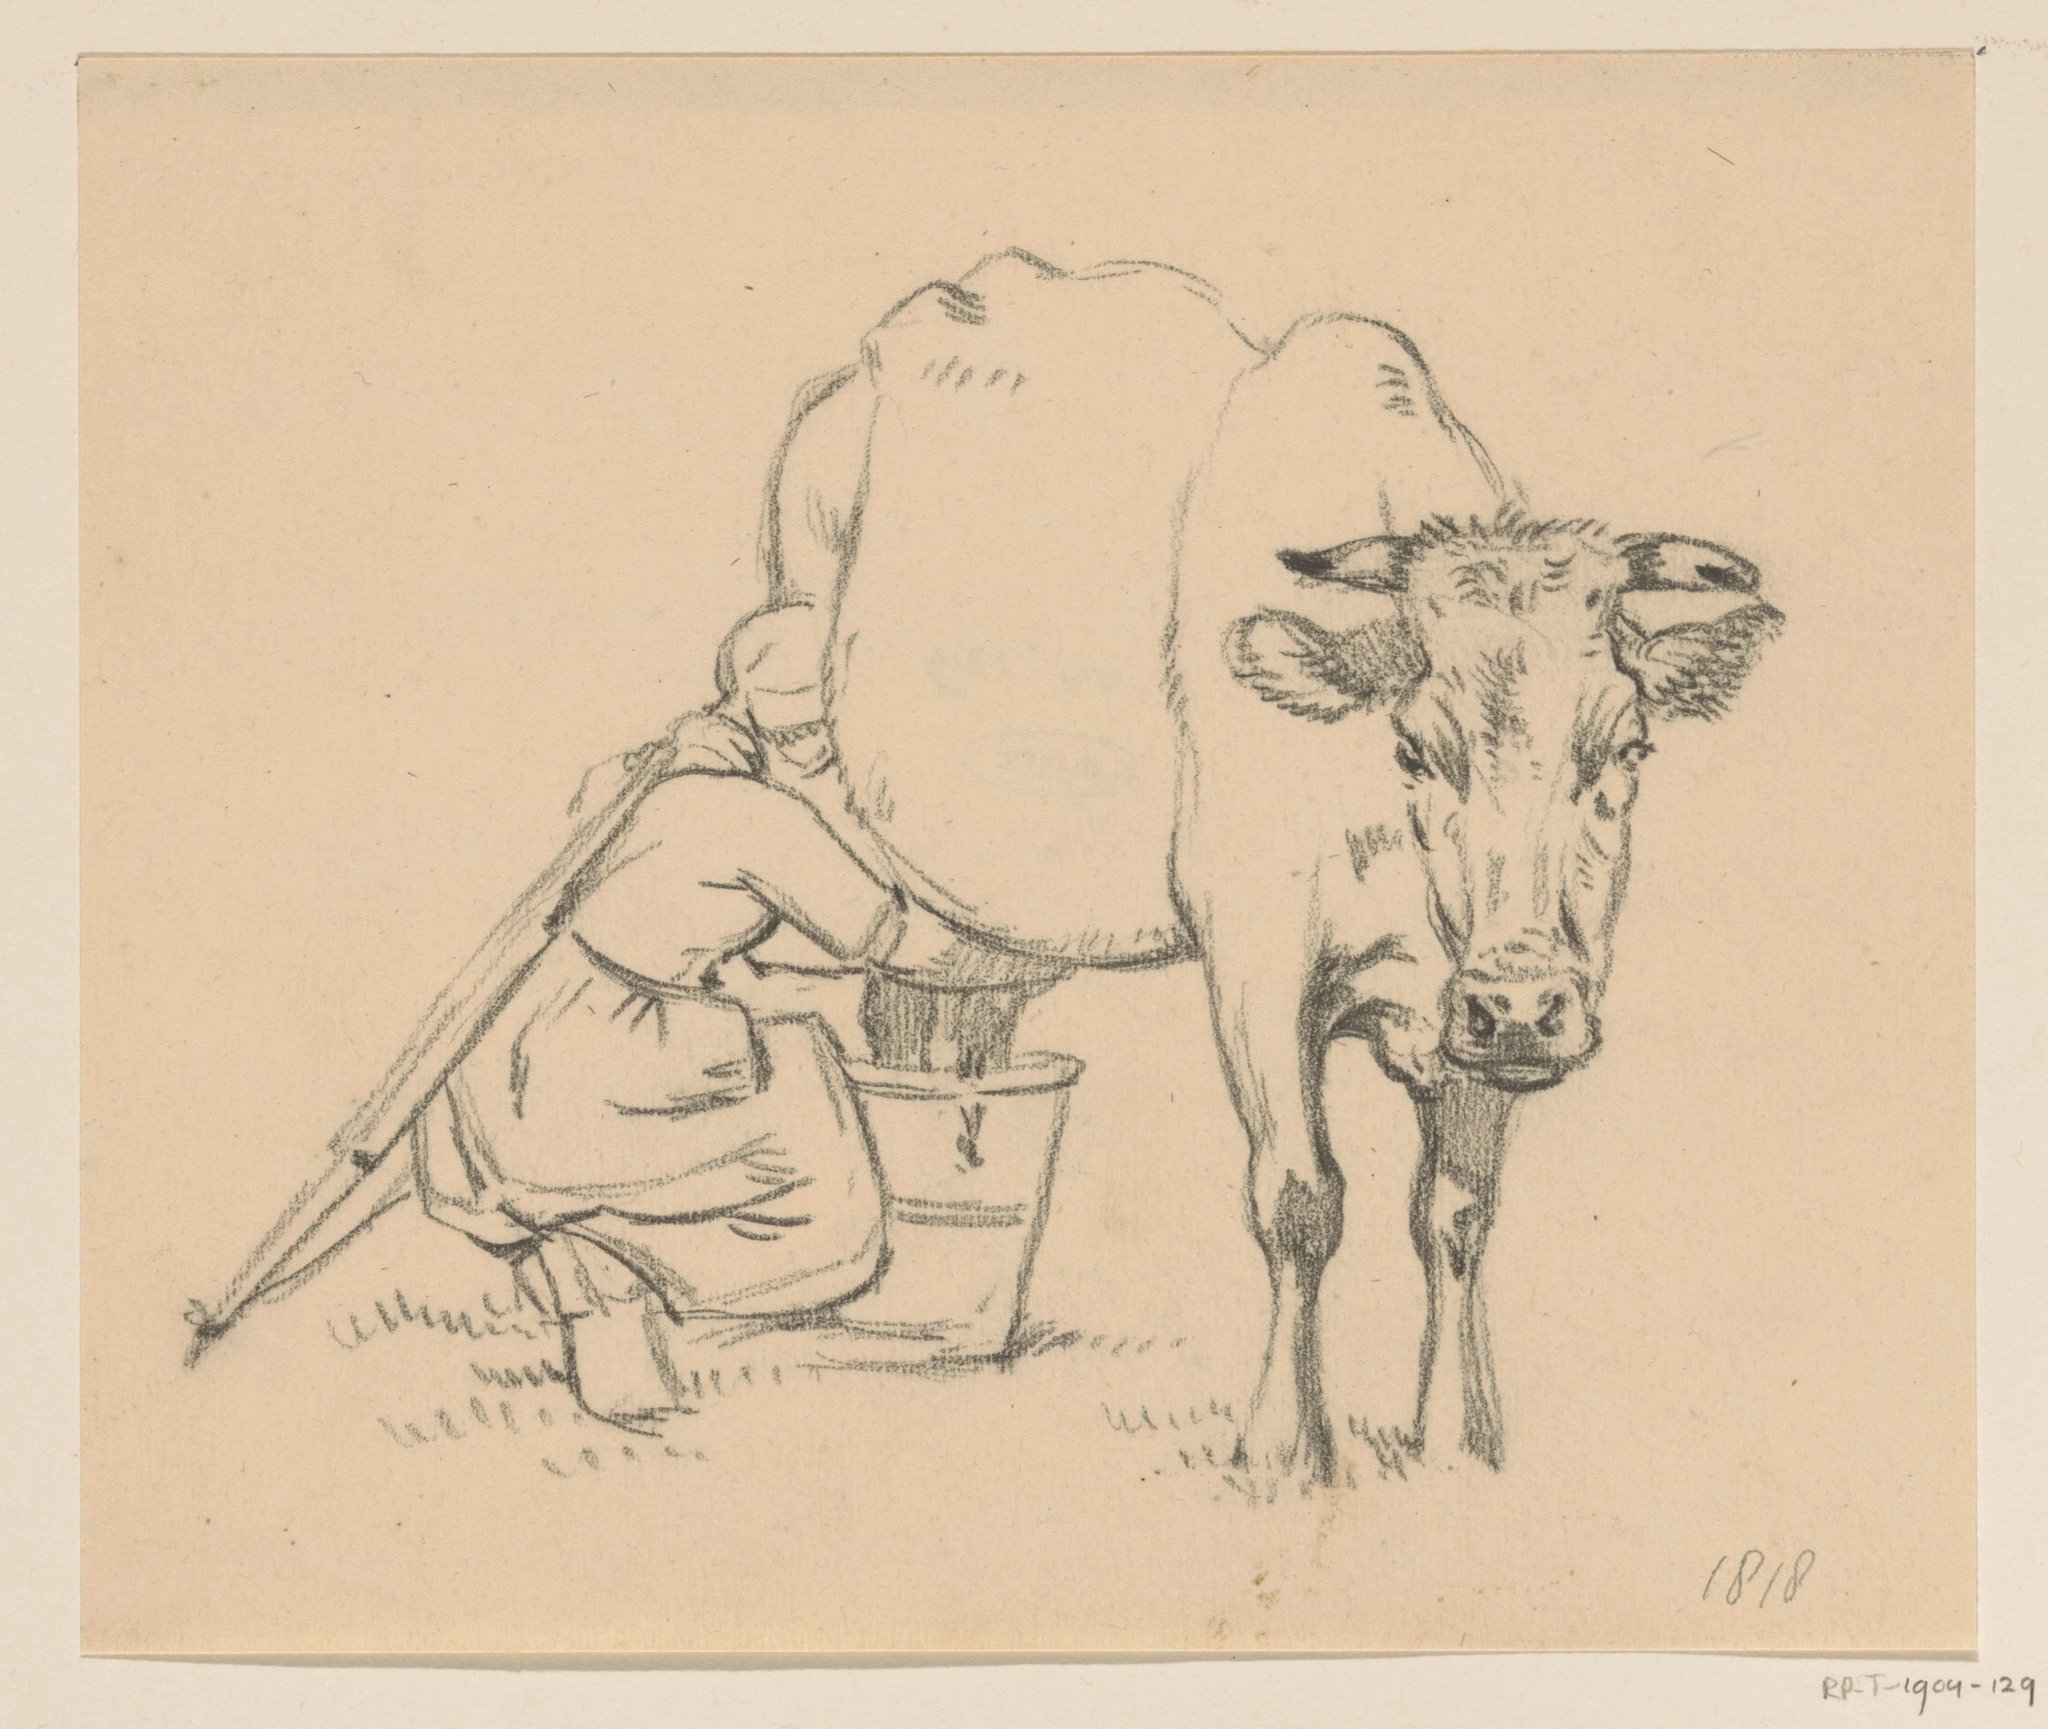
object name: drawing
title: Koe wordt gemolken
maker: jean bernard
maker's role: draughtsman, print maker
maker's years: 1765-1833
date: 1818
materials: chalk, paper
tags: cow